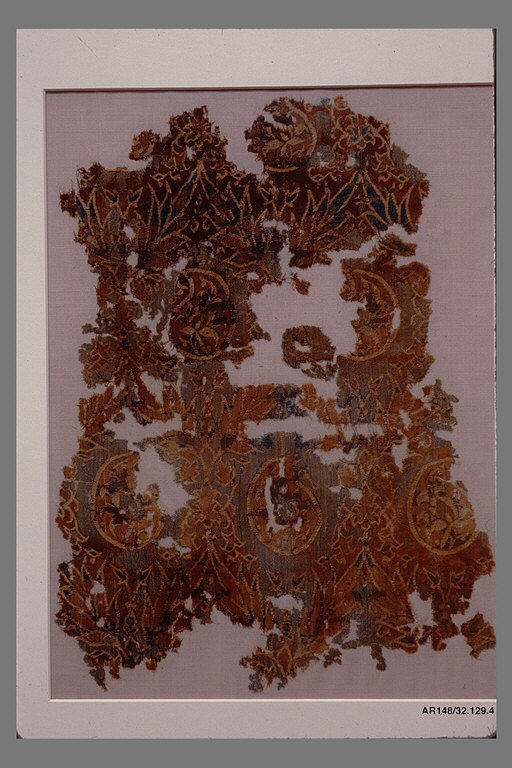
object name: textile fragment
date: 1301-1400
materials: silk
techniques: compound weave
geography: egypt